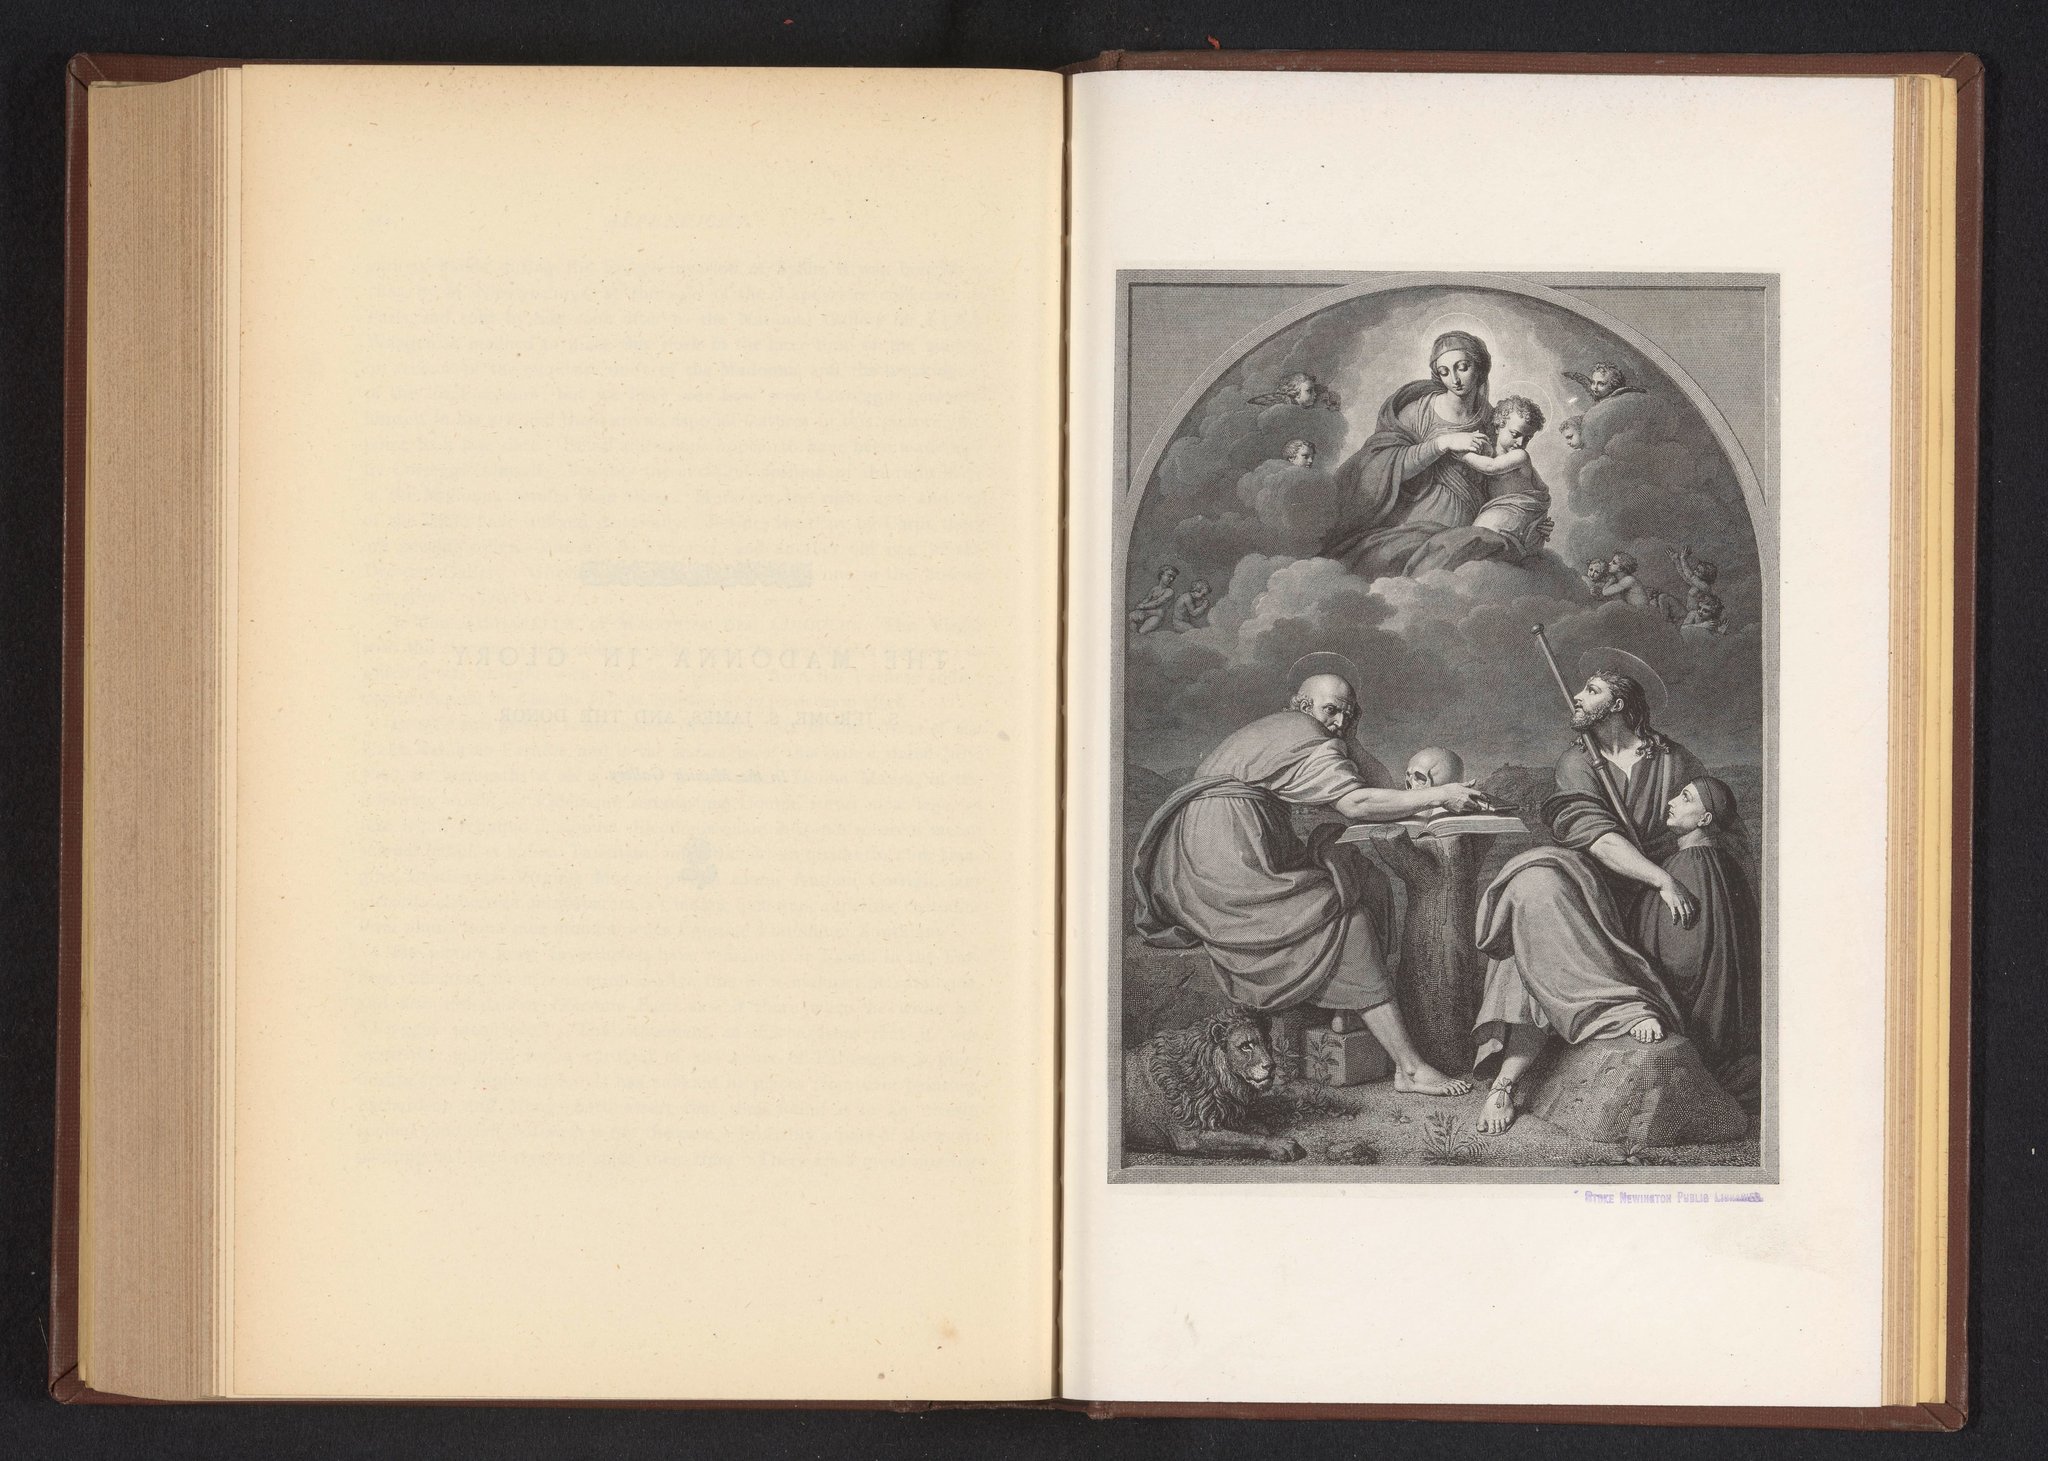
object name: photomechanical print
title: Fotoreproductie van een prent naar een schilderij, voorstellende de tronende Madonna met de heilige Hiëronymus en Jacobus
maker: Anonymous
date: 1870-1876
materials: paper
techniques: photograph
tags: madonna: mary sitting or enthroned, the christ-child in her lap (or in front of her bosom) (mary sometimes represented half-length), the apostle james the less, first bishop of jerusalem; possible attributes: book, fuller's club, scroll, the monk and hermit jerome (hieronymus); possible attributes: book, cardinal's hat, crucifix, hour-glass, lion, skull, stone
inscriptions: inscription: ‘Stoke Newington Public Libraries’